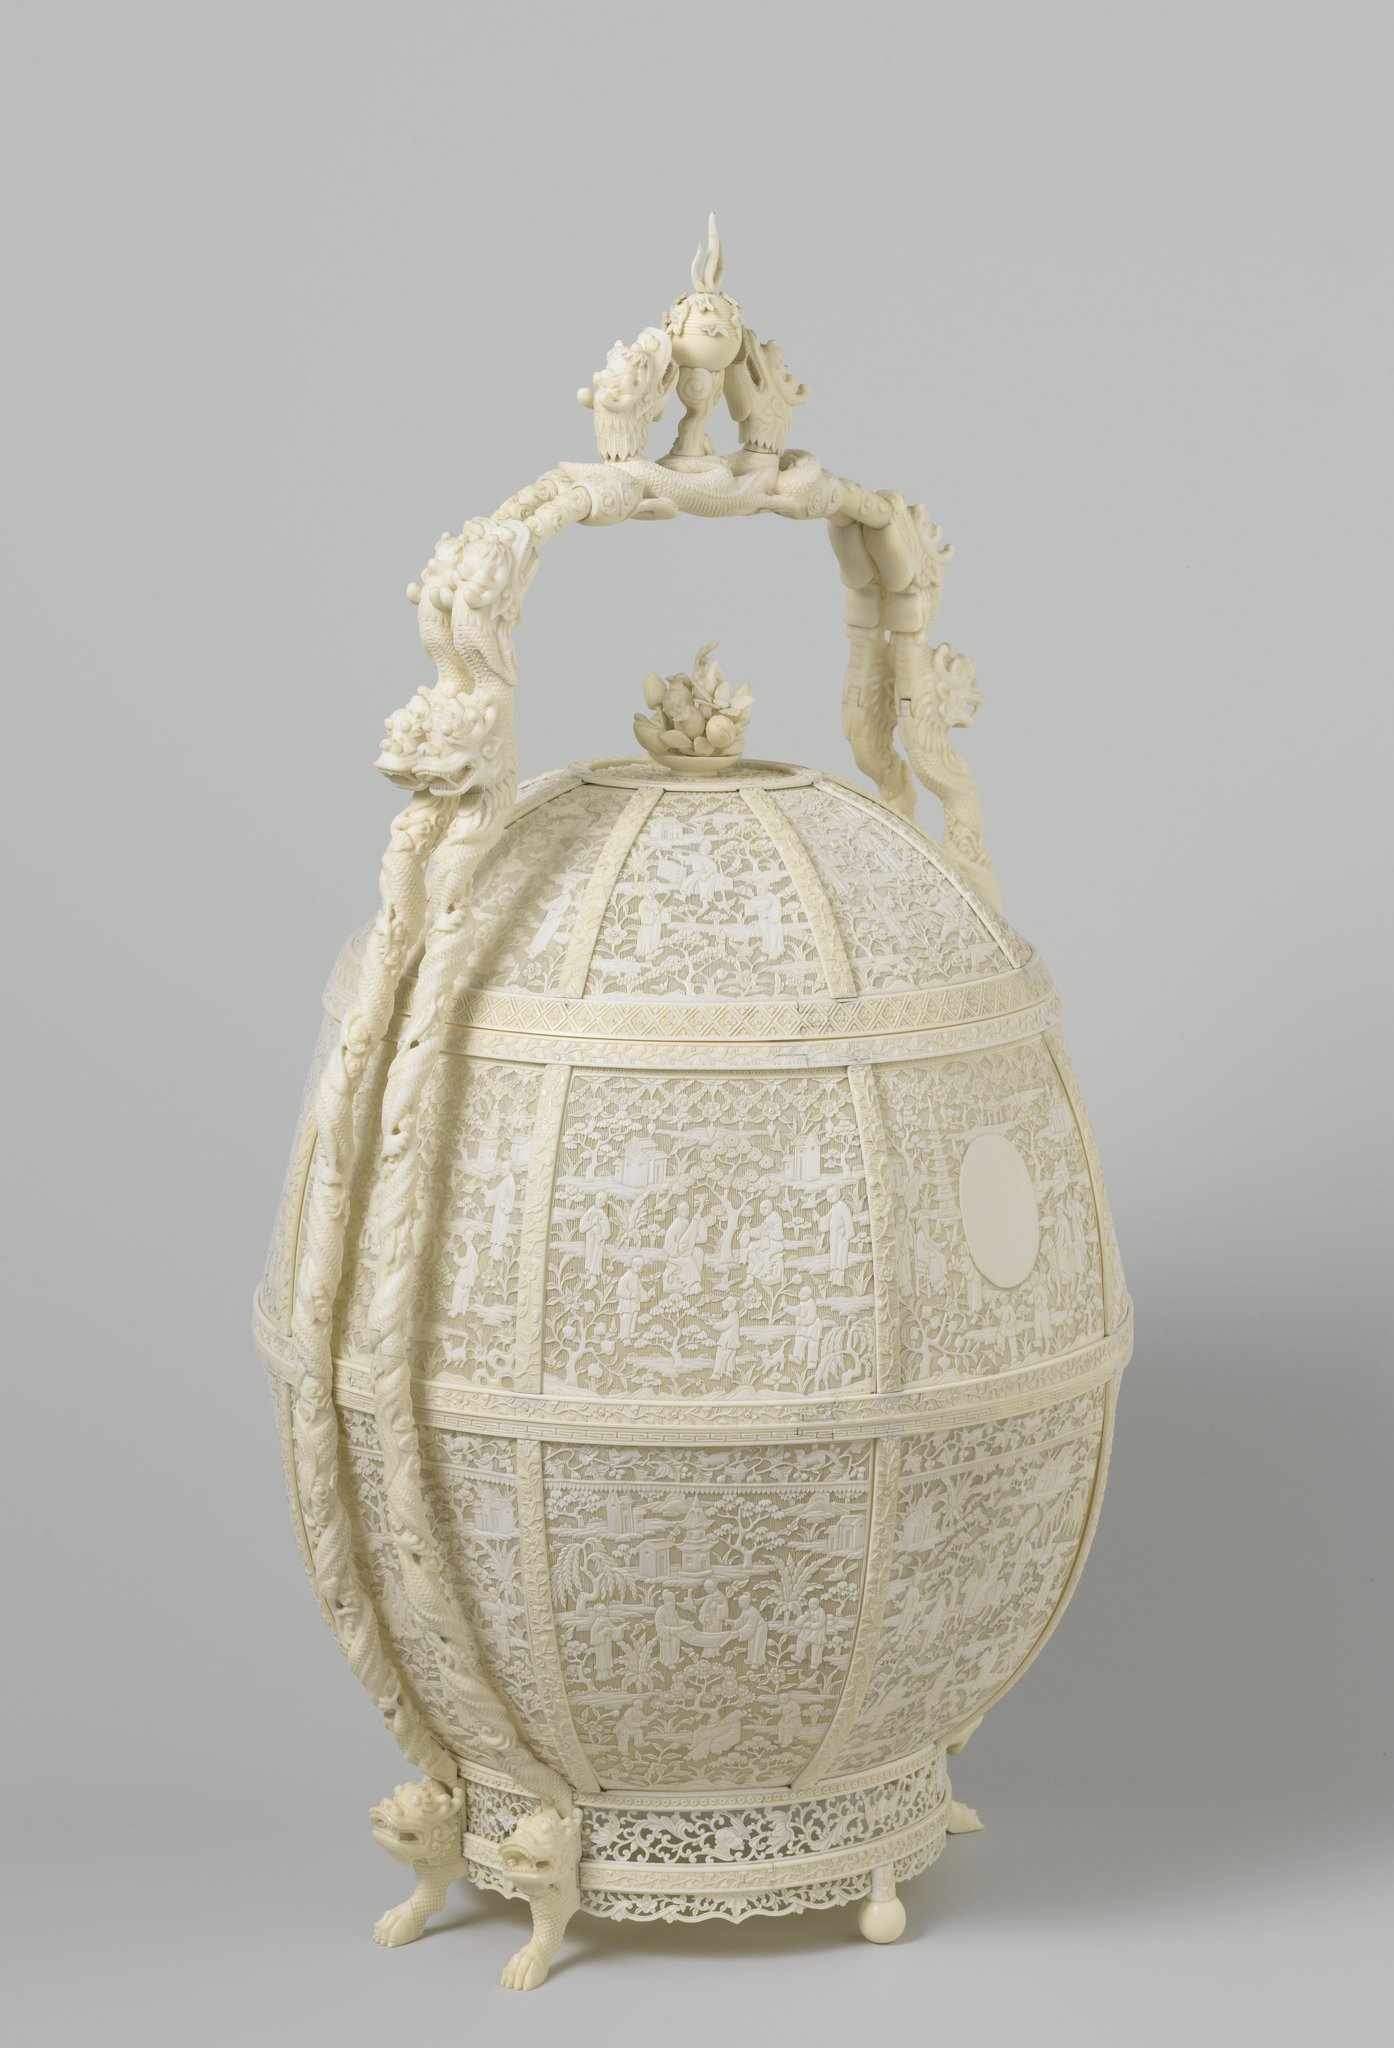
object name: basket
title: Stacking Boxes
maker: Anonymous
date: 1800-1815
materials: ivory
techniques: cutting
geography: guangdong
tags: dragon, ornament derived from plant forms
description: This pair of stacking boxes is exceedingly finely incised with figures in a detailed landscape. The boxes’ almost transparent carving indicates that they did not serve a utilitarian, but rather a decorative purpose. Due to global trade, Canton became the most important centre for processing and selling ivory. This type of openwork ivory ranks among the most costly souvenirs one could buy in Canton.